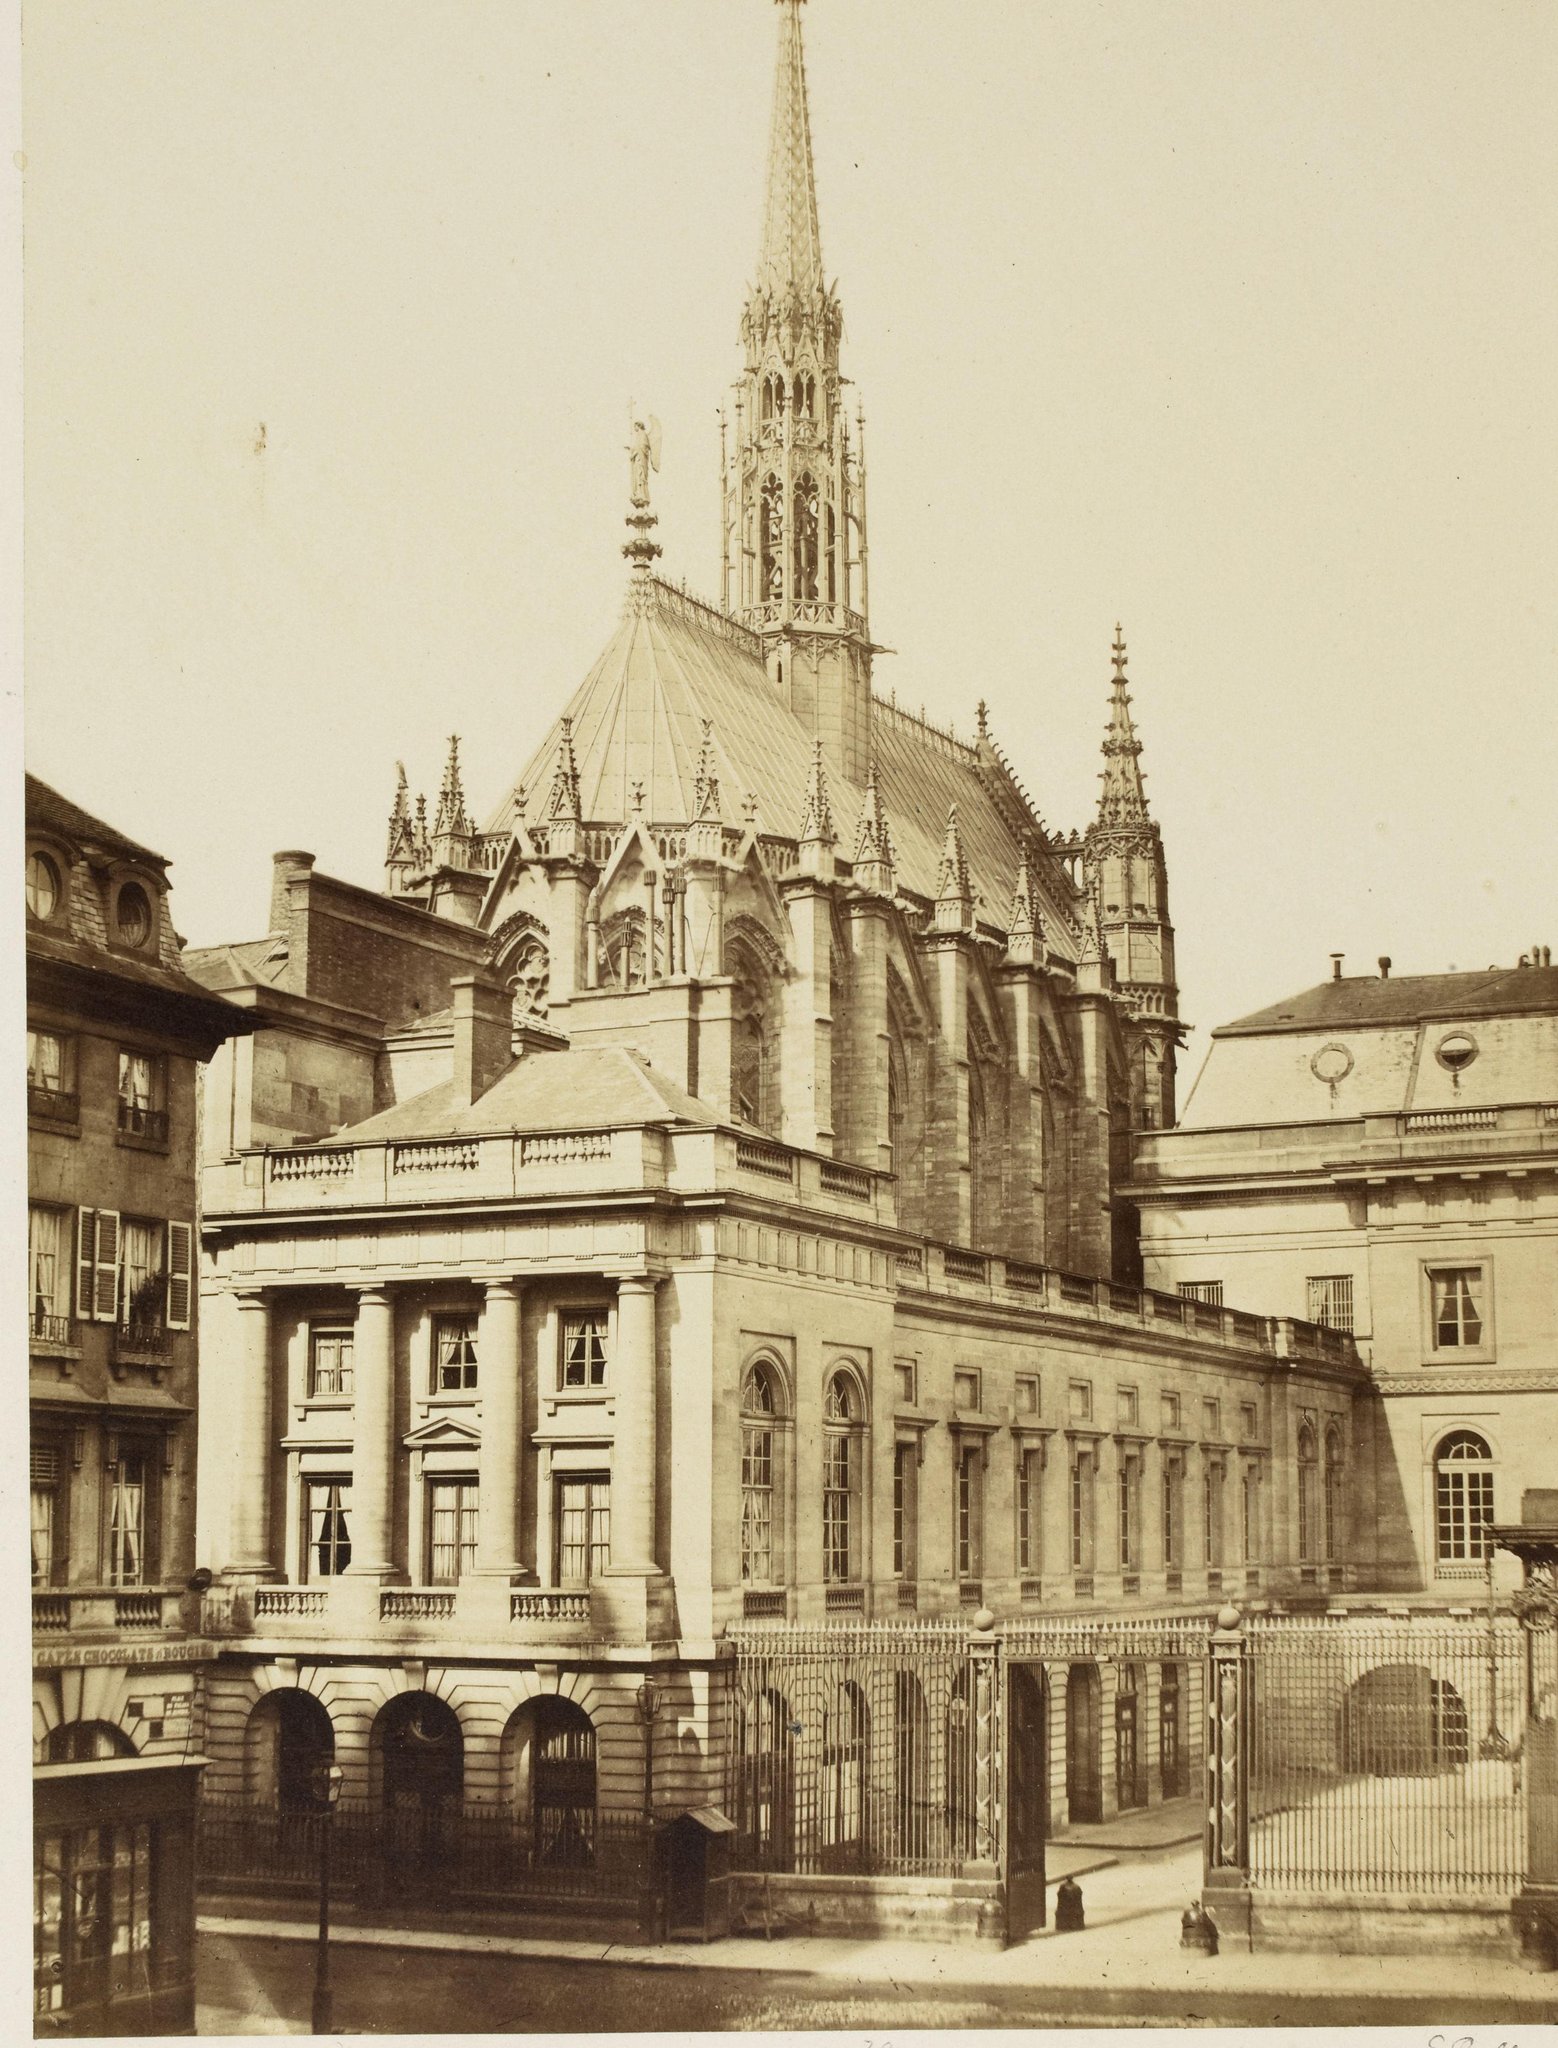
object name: photograph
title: The Sainte Chapelle Paris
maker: édouard denis baldus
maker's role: fotograaf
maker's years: 1813-1889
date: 1855-1865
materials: cardboard, paper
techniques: salted paper print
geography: paris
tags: church (exterior), hôtel, i.e. small palace in city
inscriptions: inscription: ‘BALDUS/ Ref 0490/ 2’, stamp: ‘E. Baldus’, check stamp: ‘Architectural Photographic Association’